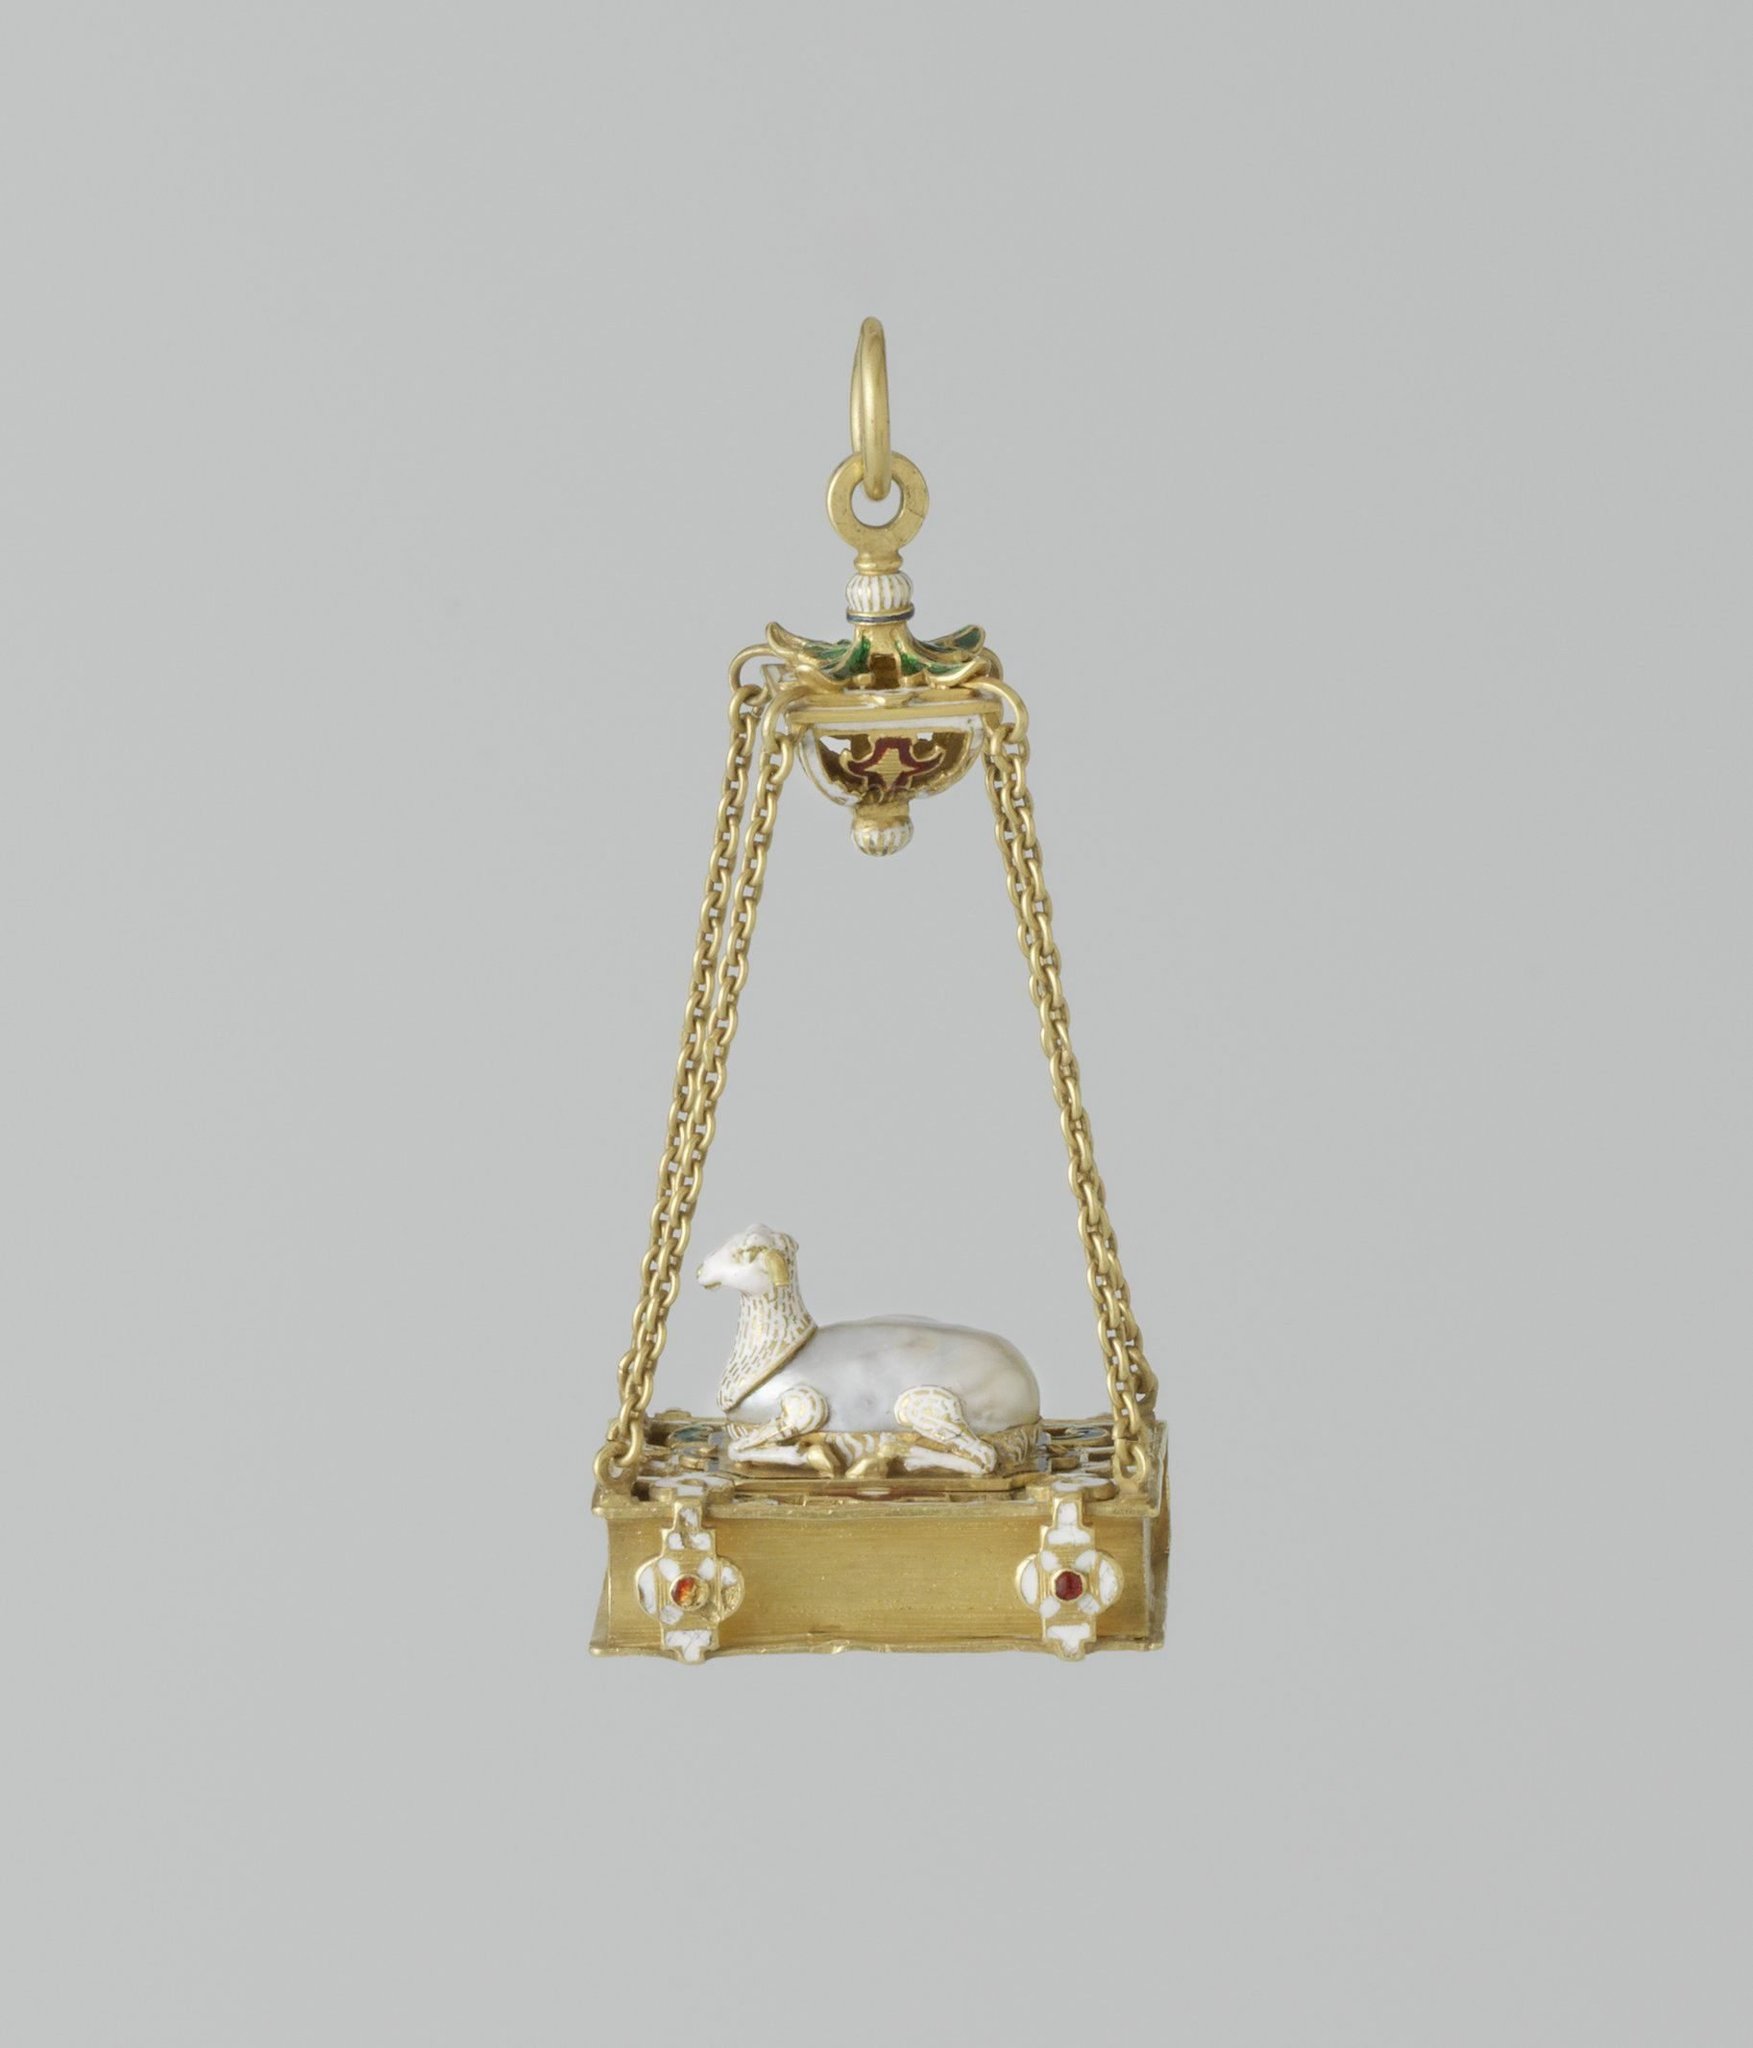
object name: ear ornament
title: Oorhanger met lam op het boek met zeven zegels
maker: Anonymous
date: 1580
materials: gold, pearl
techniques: painted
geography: central europe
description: Two pendants. Lamb on a book. Gold, pearls and enamel. Germany, c. 1550-1600.